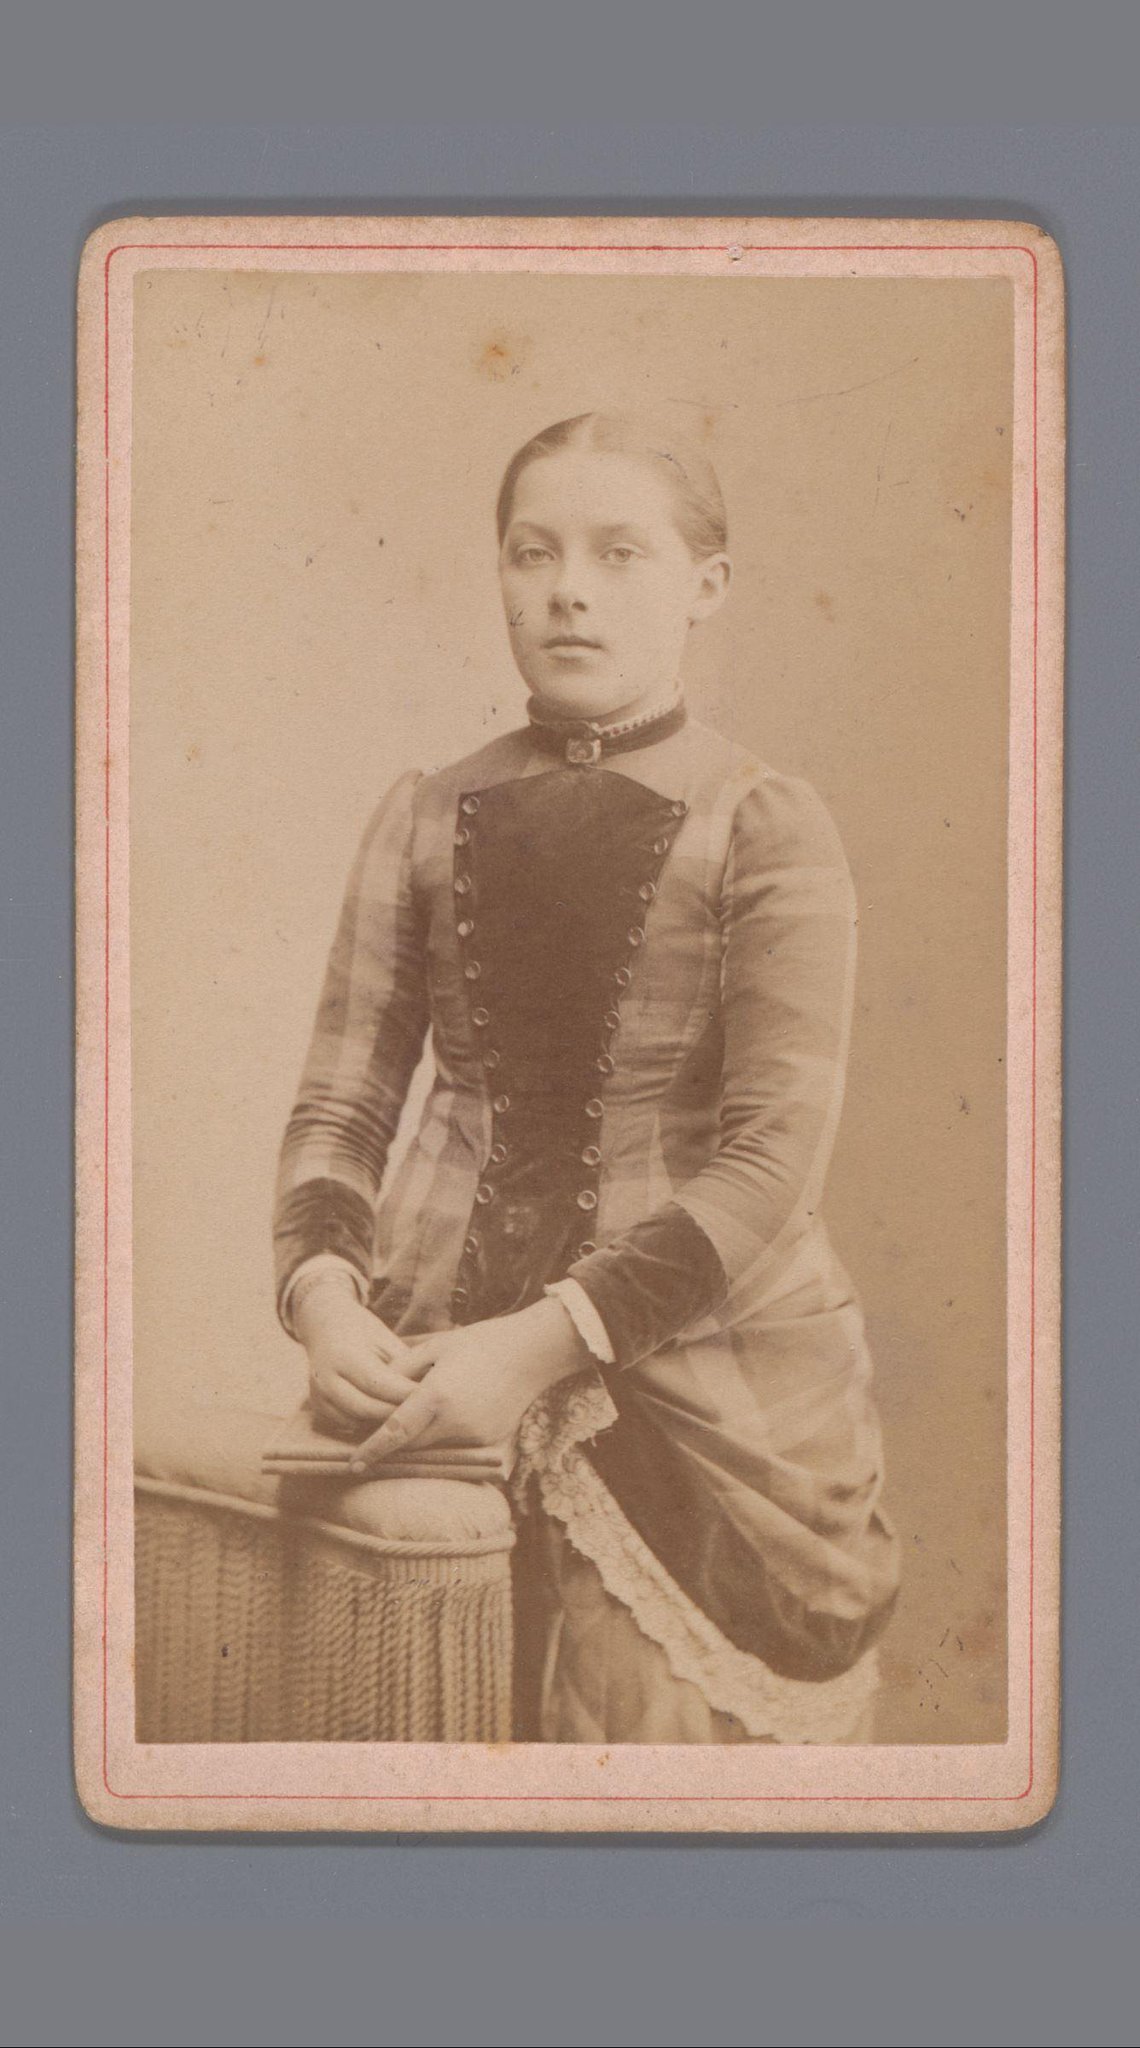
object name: carte de visite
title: Portret van Grietje Welt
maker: friedrich julius von kolkow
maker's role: fotograaf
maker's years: 1839-1914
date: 1884-1896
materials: cardboard, paper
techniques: albumen print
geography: groningen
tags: historical persons - bb - woman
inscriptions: inscription: ‘Grietje Welt’, inscription: ‘GOUDEN MEDALJE VOOR KUNST EN WETENSCHAP v Z. M. de KONING v WÜRTTEMBERG/ aan het lint der Frederiksorde/ PHILADELPHIA 1876. WIEN 1873./ FR. JUL. VON KOLKOW/ KONINKLIJK NEDERLANDSCH HOF-PHOTOGRAPH/ Silberne Voigtländer Medialle Kunst u Wissenschaft Oldenburg/ en tien zilveren Medaljes op andere Tentoonstellingen./ GRONINGEN/ Groote Markt bij de/ Martinitoorn./ Specialiteit in Vergrootingen.’